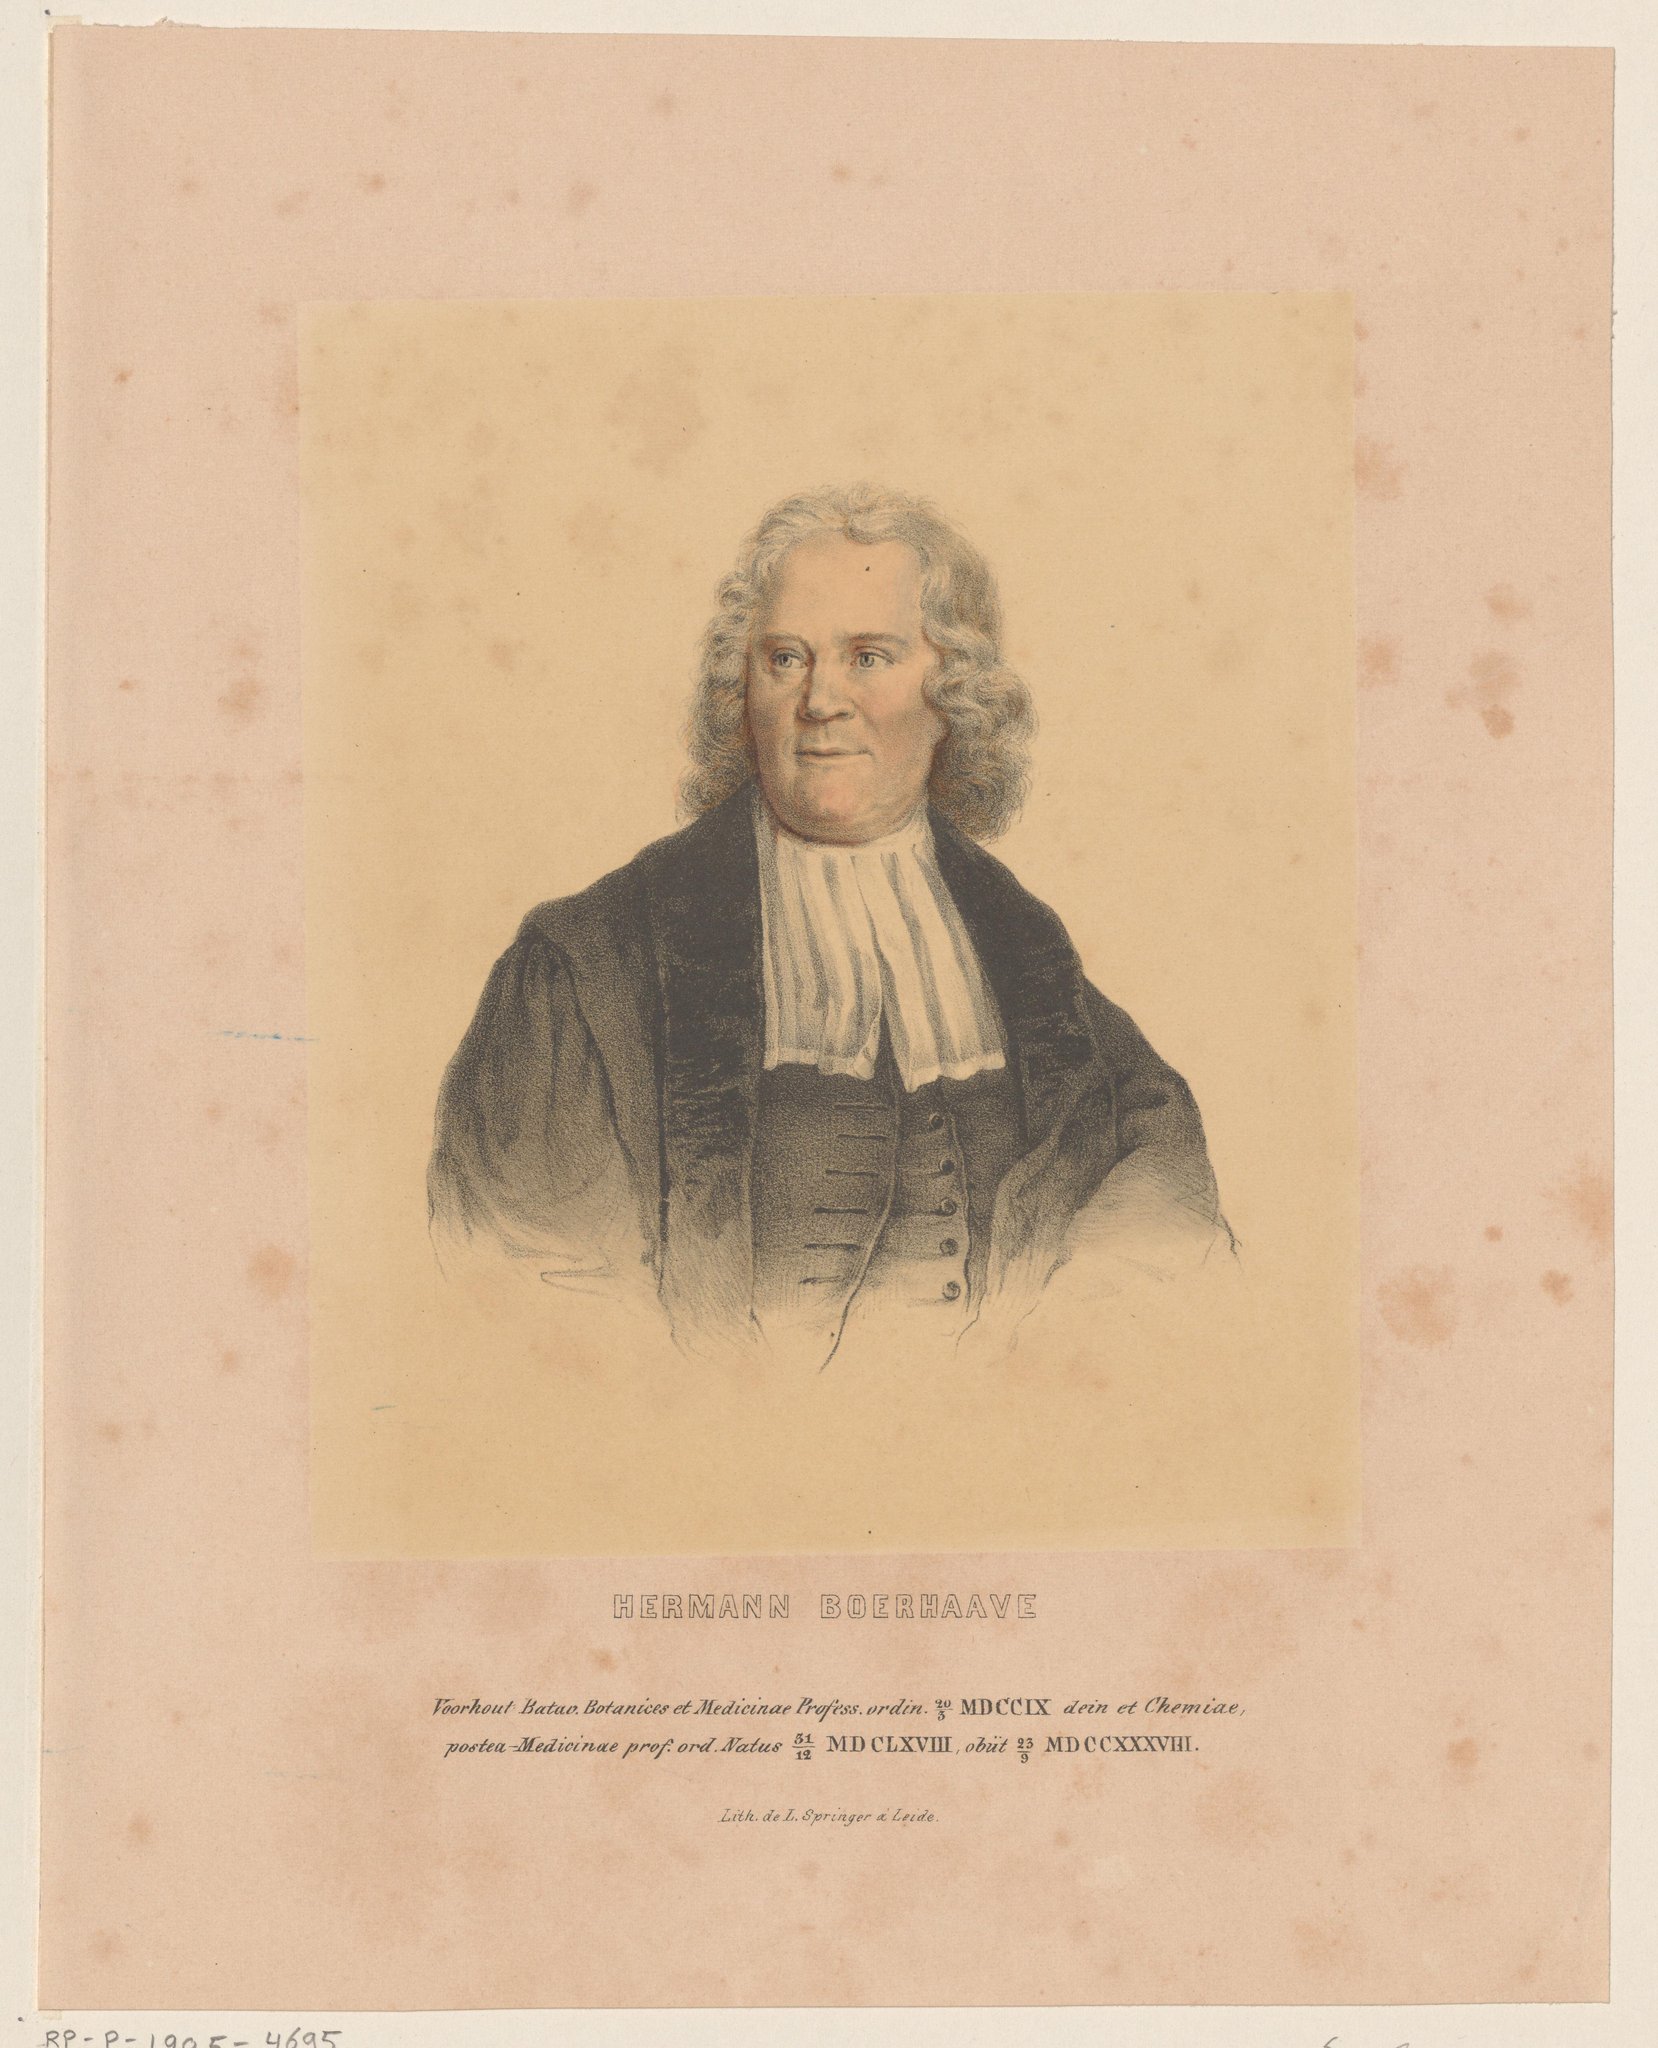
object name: print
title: Portret van Hermanus Boerhaave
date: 1830-1853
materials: paper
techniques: hand coloring, intaglio, lithograph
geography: leiden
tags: leiden, hermanus boerhaave, historical persons, physician, doctor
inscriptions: collector's mark: Lugt 2228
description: Prent waarschijnlijk uit: Galerij van hoogleeraren aan de Hoogeschool te Leijden (...). Leiden: L. Springer, 1850.